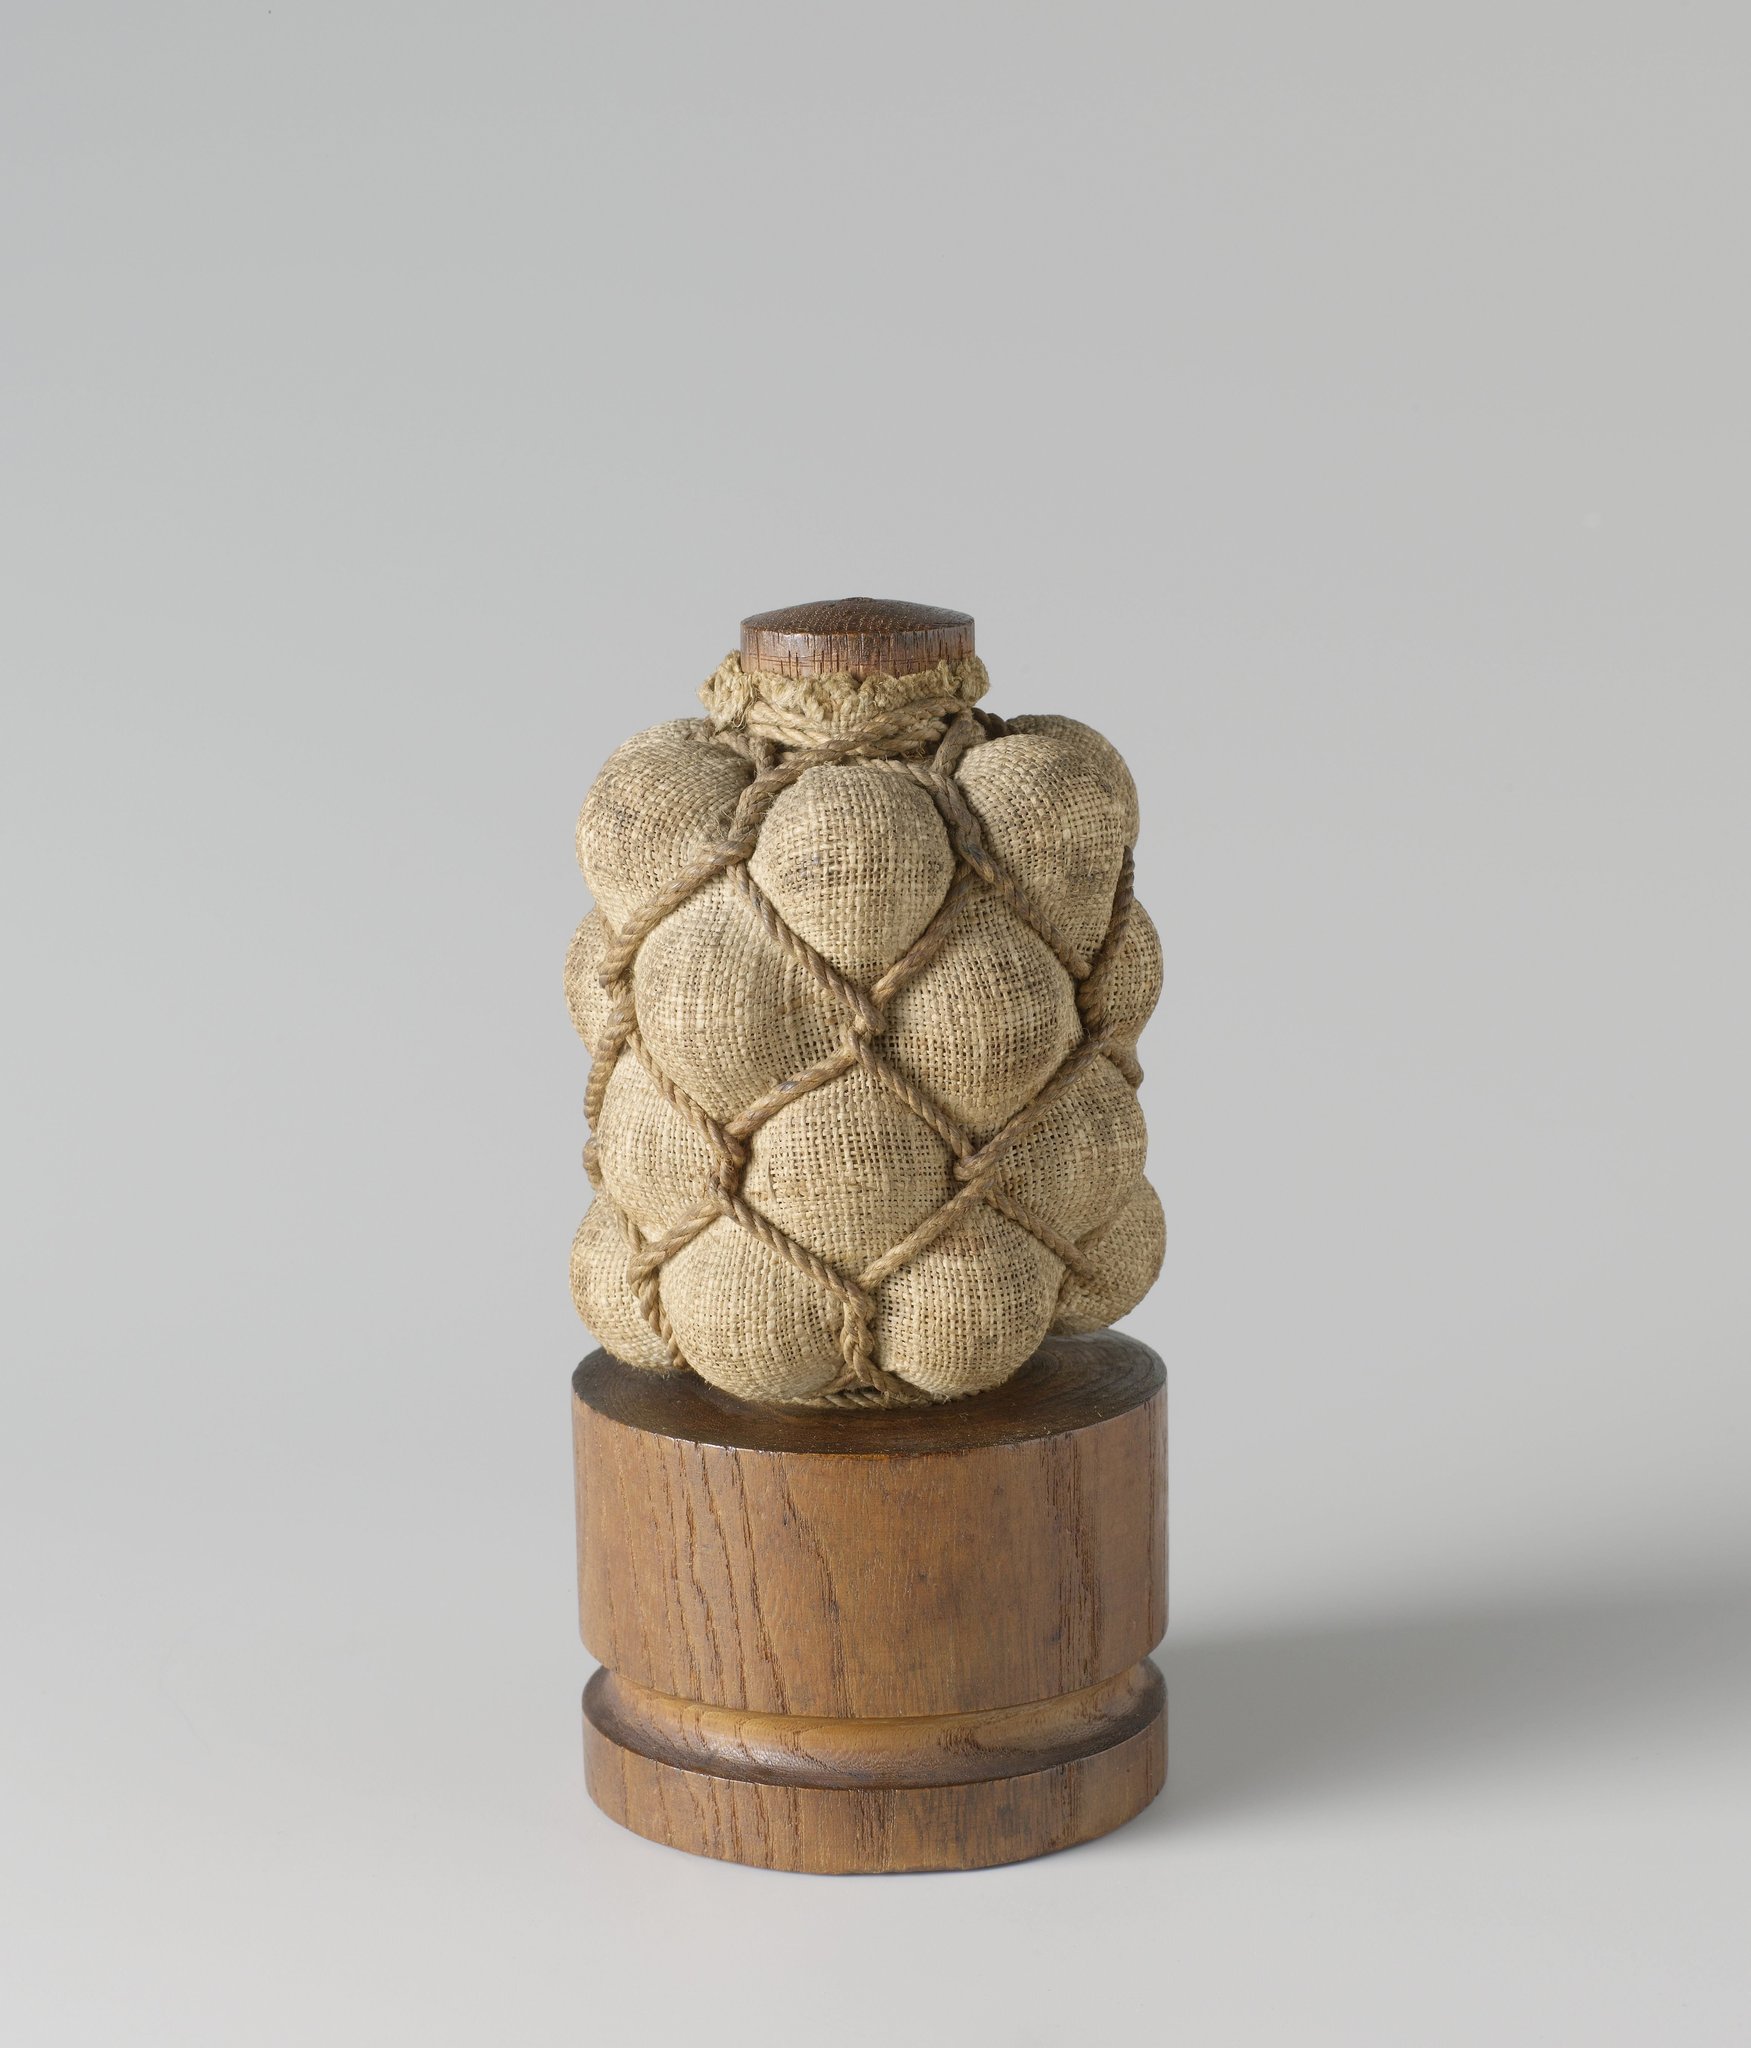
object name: scale model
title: Models of shot bundles (grapeshot)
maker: Anonymous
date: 1750-1800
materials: iron, linen, wood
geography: netherlands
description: A cannon could be loaded with a single cannonball or bundles of smaller projectiles, such as this ‘grapeshot’. Grapeshot consisted of a canvas bag filled with iron balls or metal slugs, tied together so that it resembled a bunch of grapes. It was used to hit living targets – horses and soldiers – at close range. The Dutch word for machine gun (mitrailleur) comes from the French term for grapeshot (boîte à mitraille).